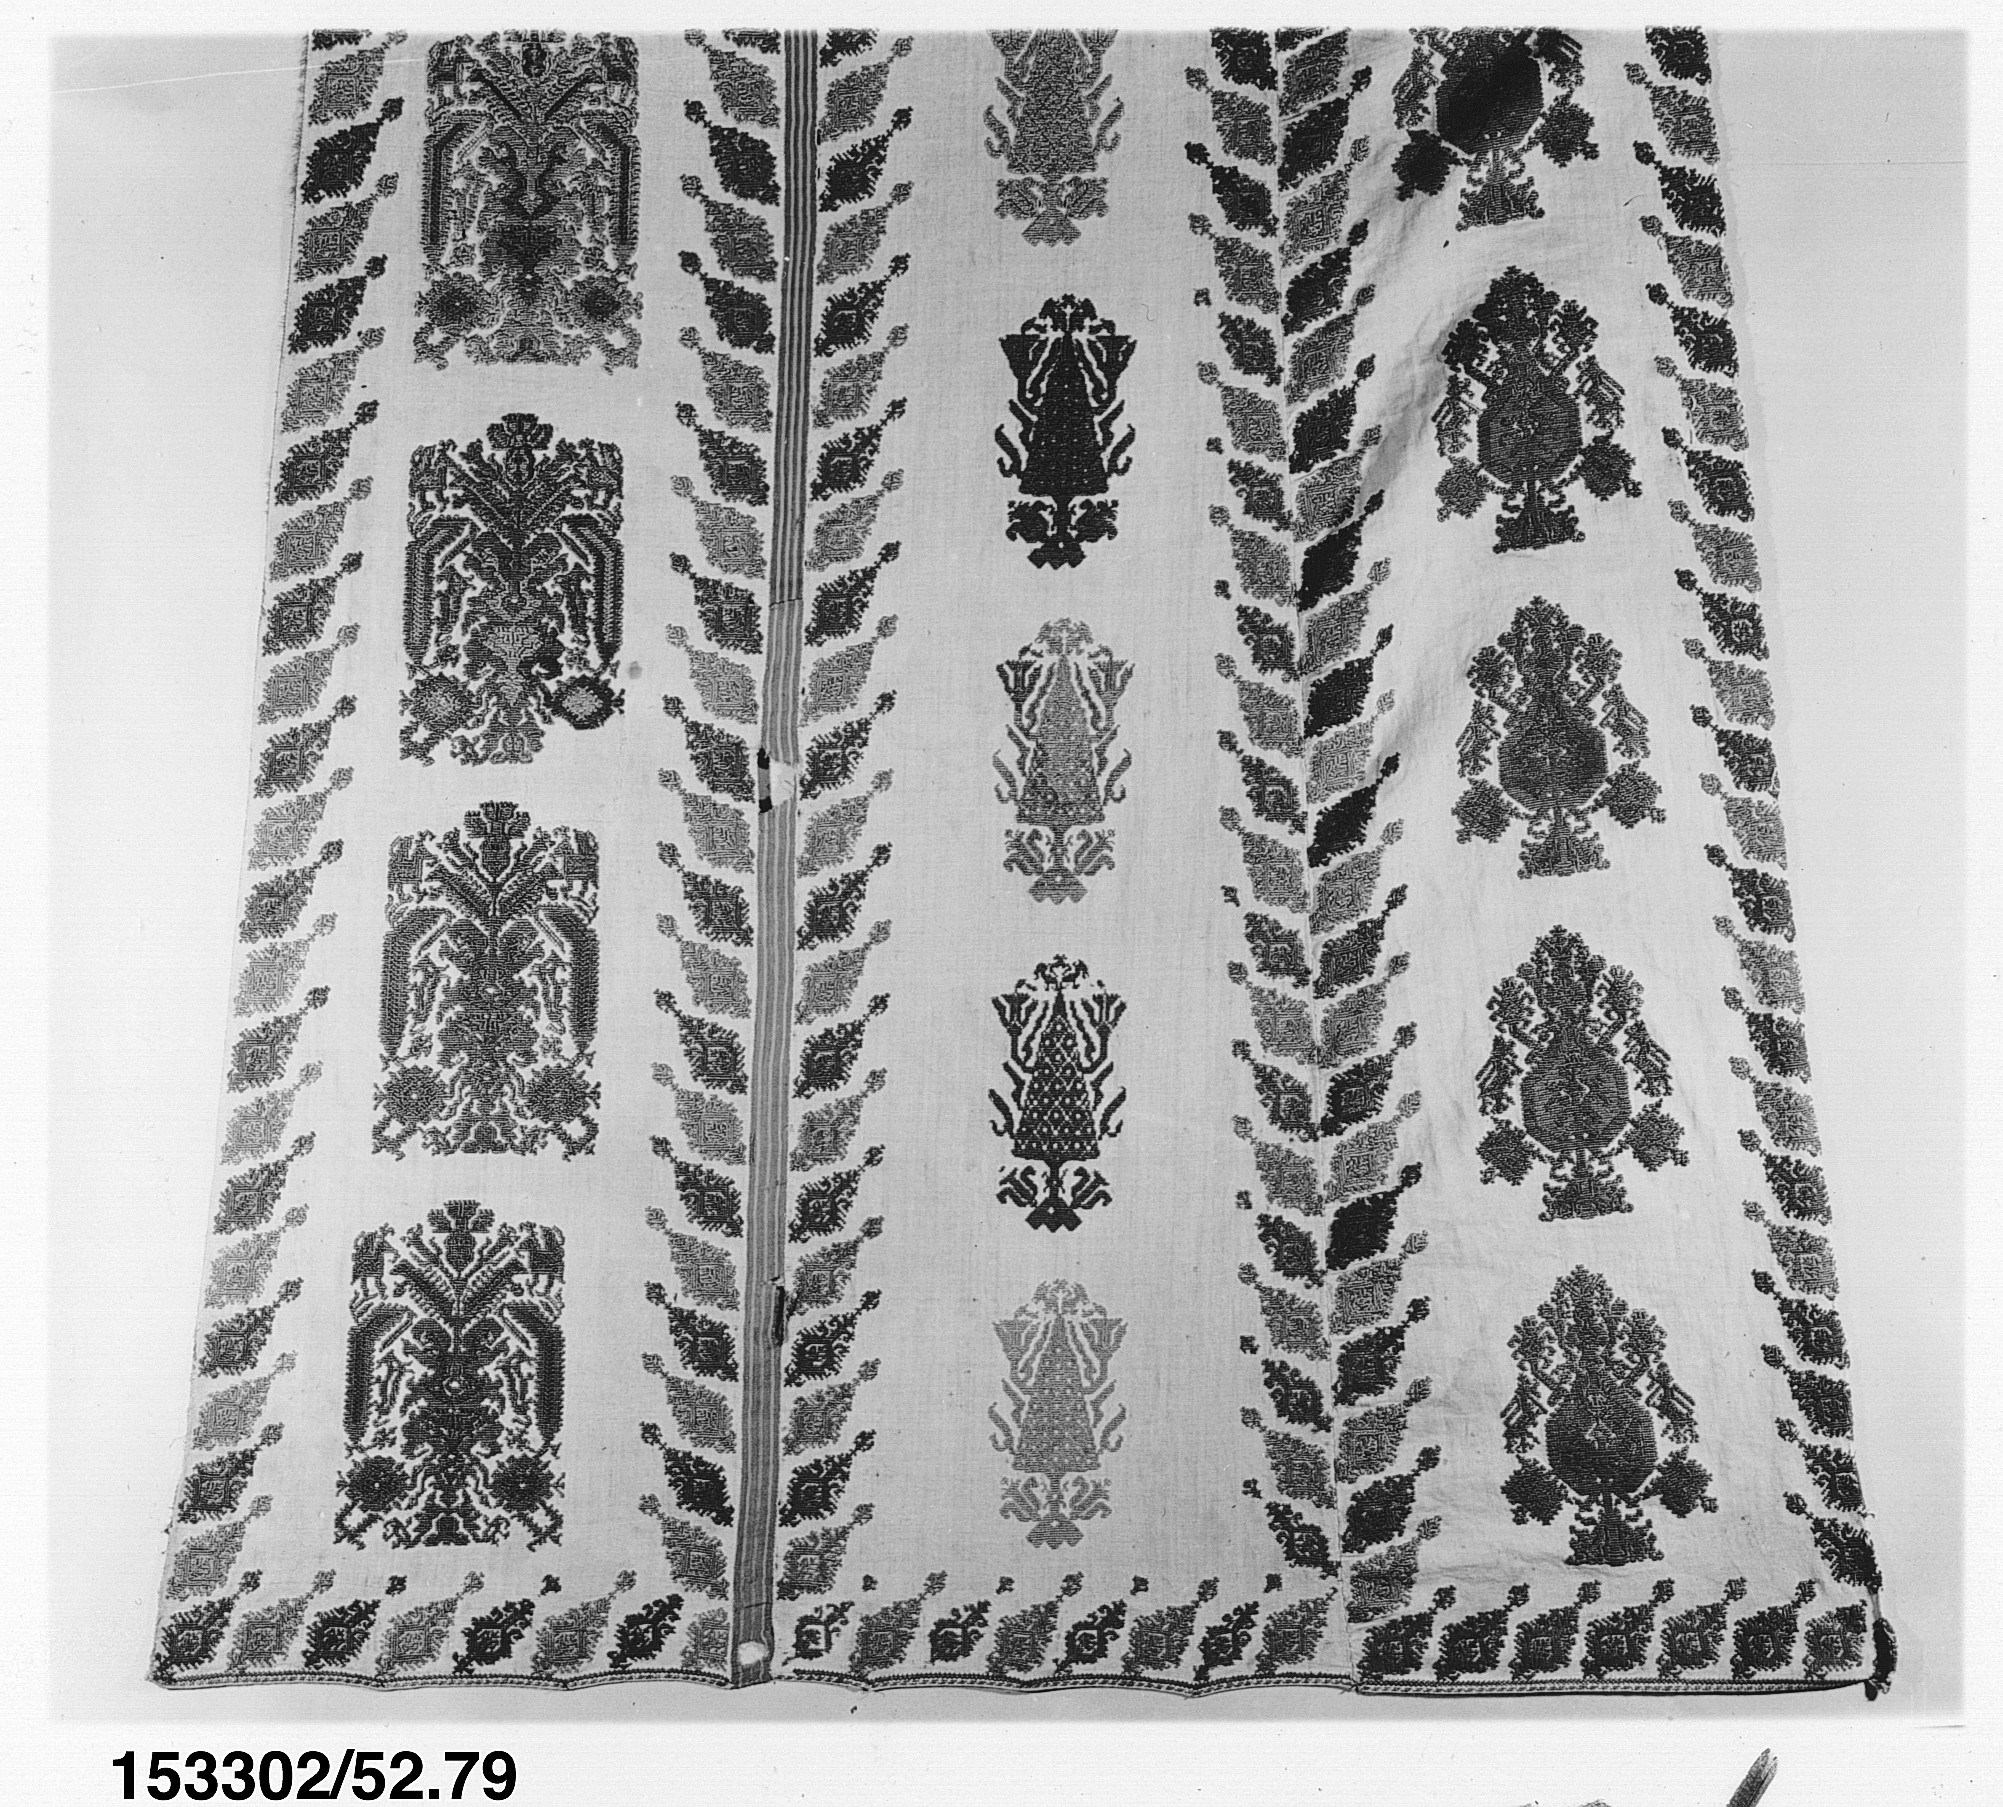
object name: bed tent panel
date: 1701-1800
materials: linen, silk